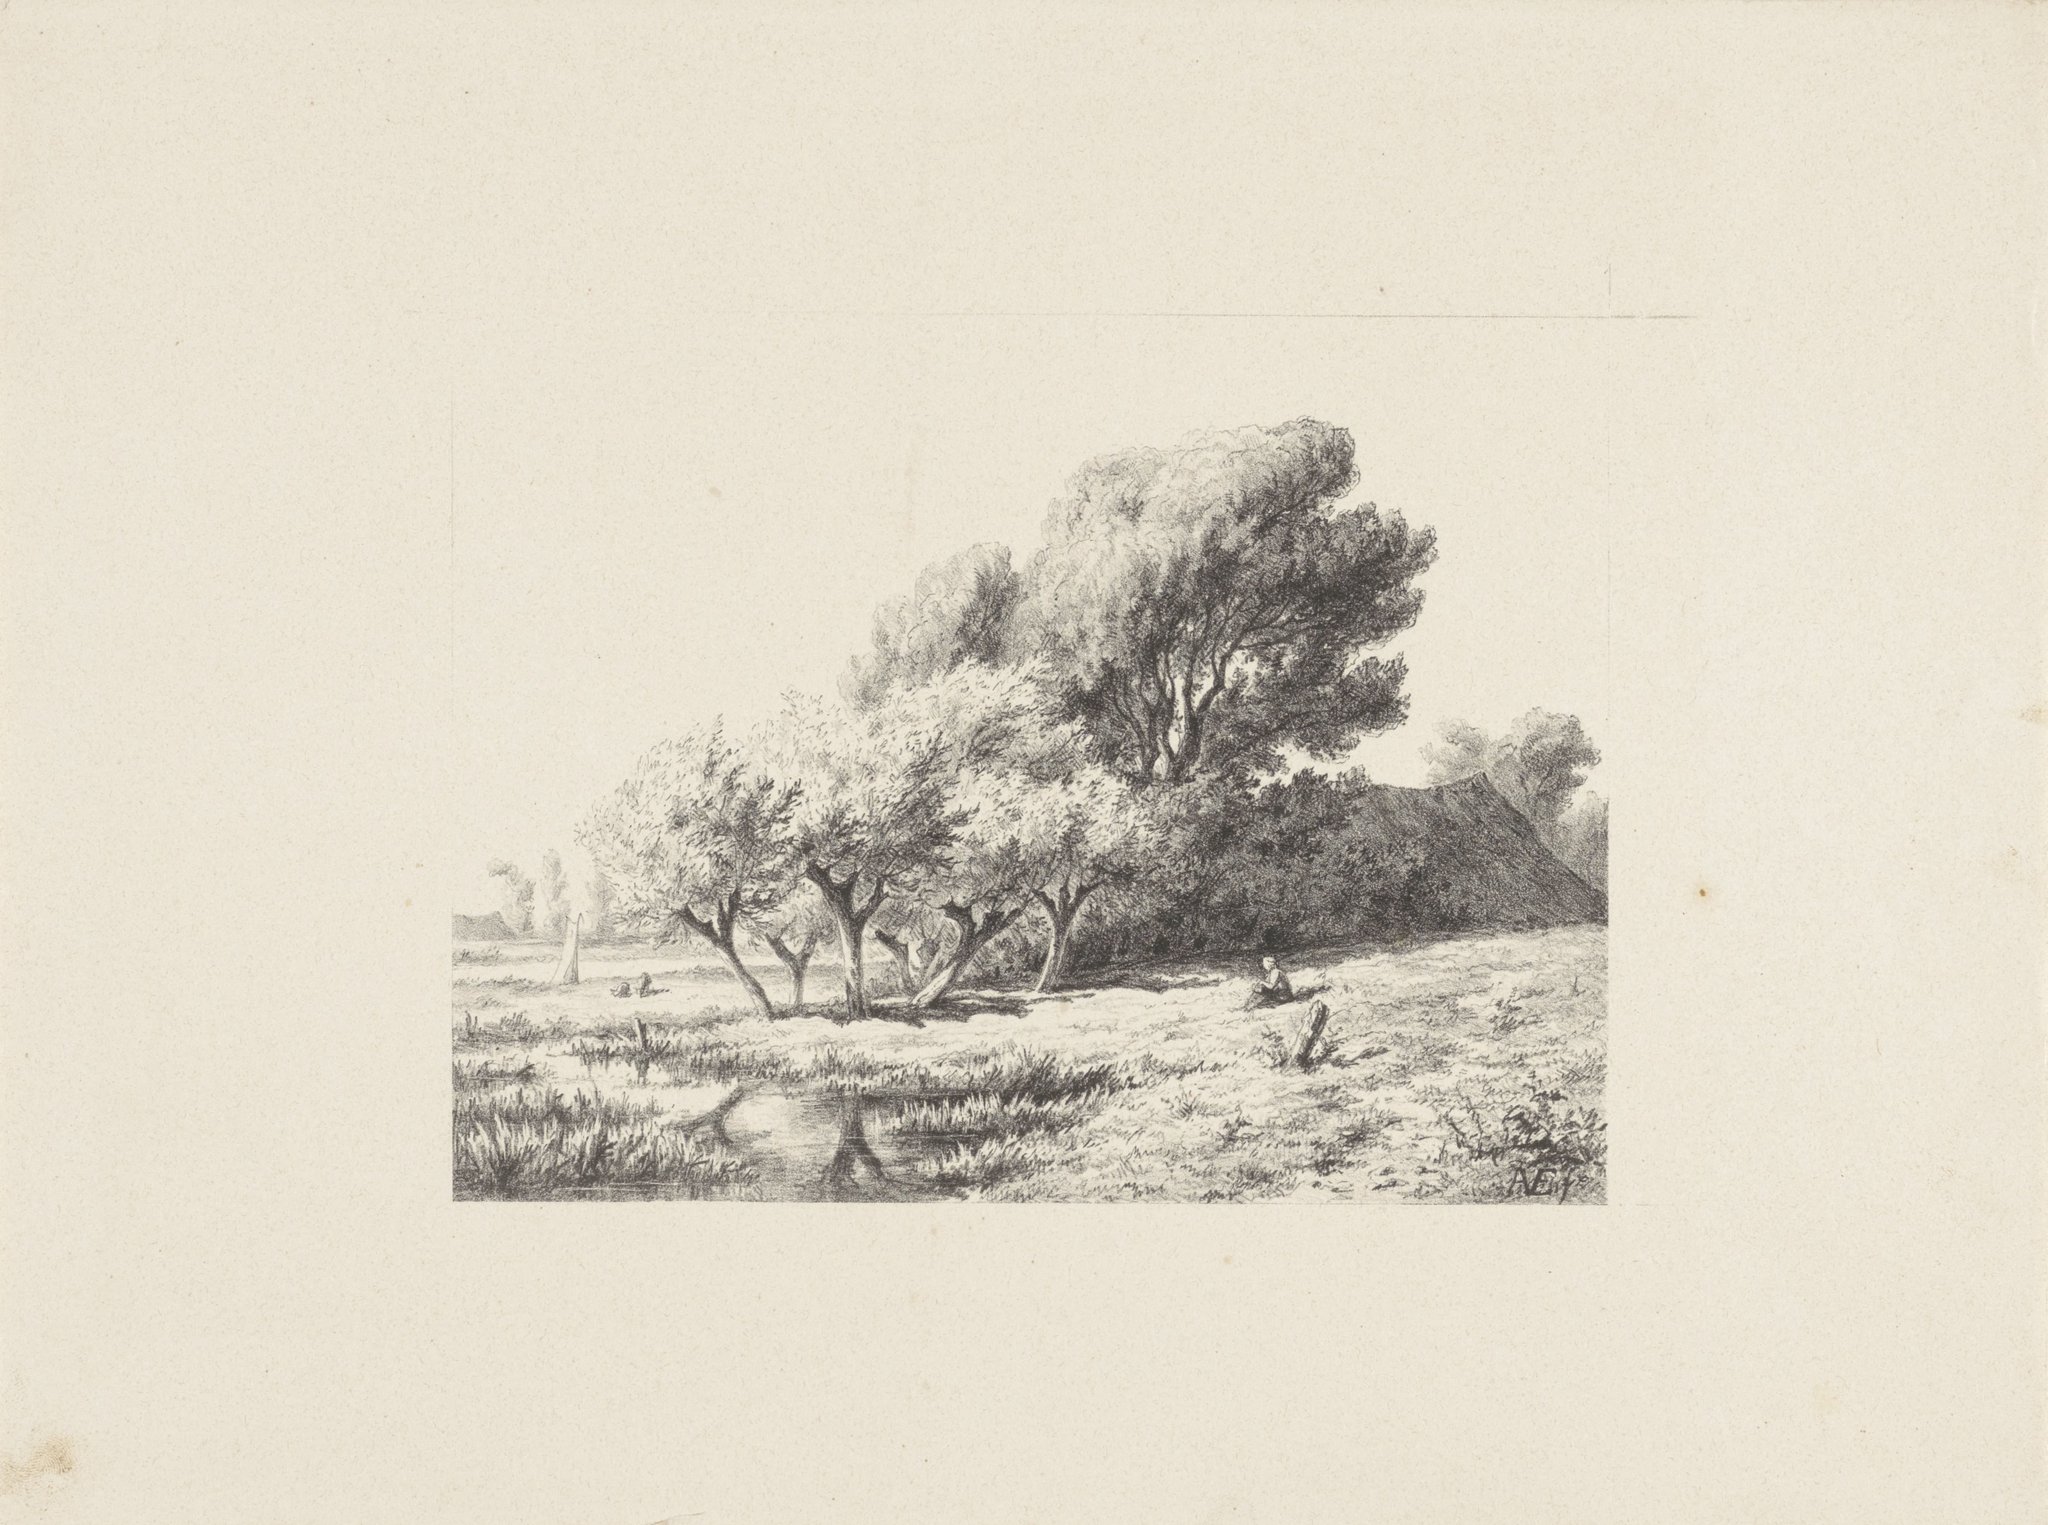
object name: print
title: Landschap met plaggenhut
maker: adrianus van everdingen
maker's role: print maker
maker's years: 1832-1912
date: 1842-1912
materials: paper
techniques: lithograph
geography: netherlands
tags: meadow, pasture, farm or solitary house in landscape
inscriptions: collector's mark: Lugt 2228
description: De plaggenhut staat beschut onder een groep bomen. Links loopt een beek. In het weiland zit een figuur.